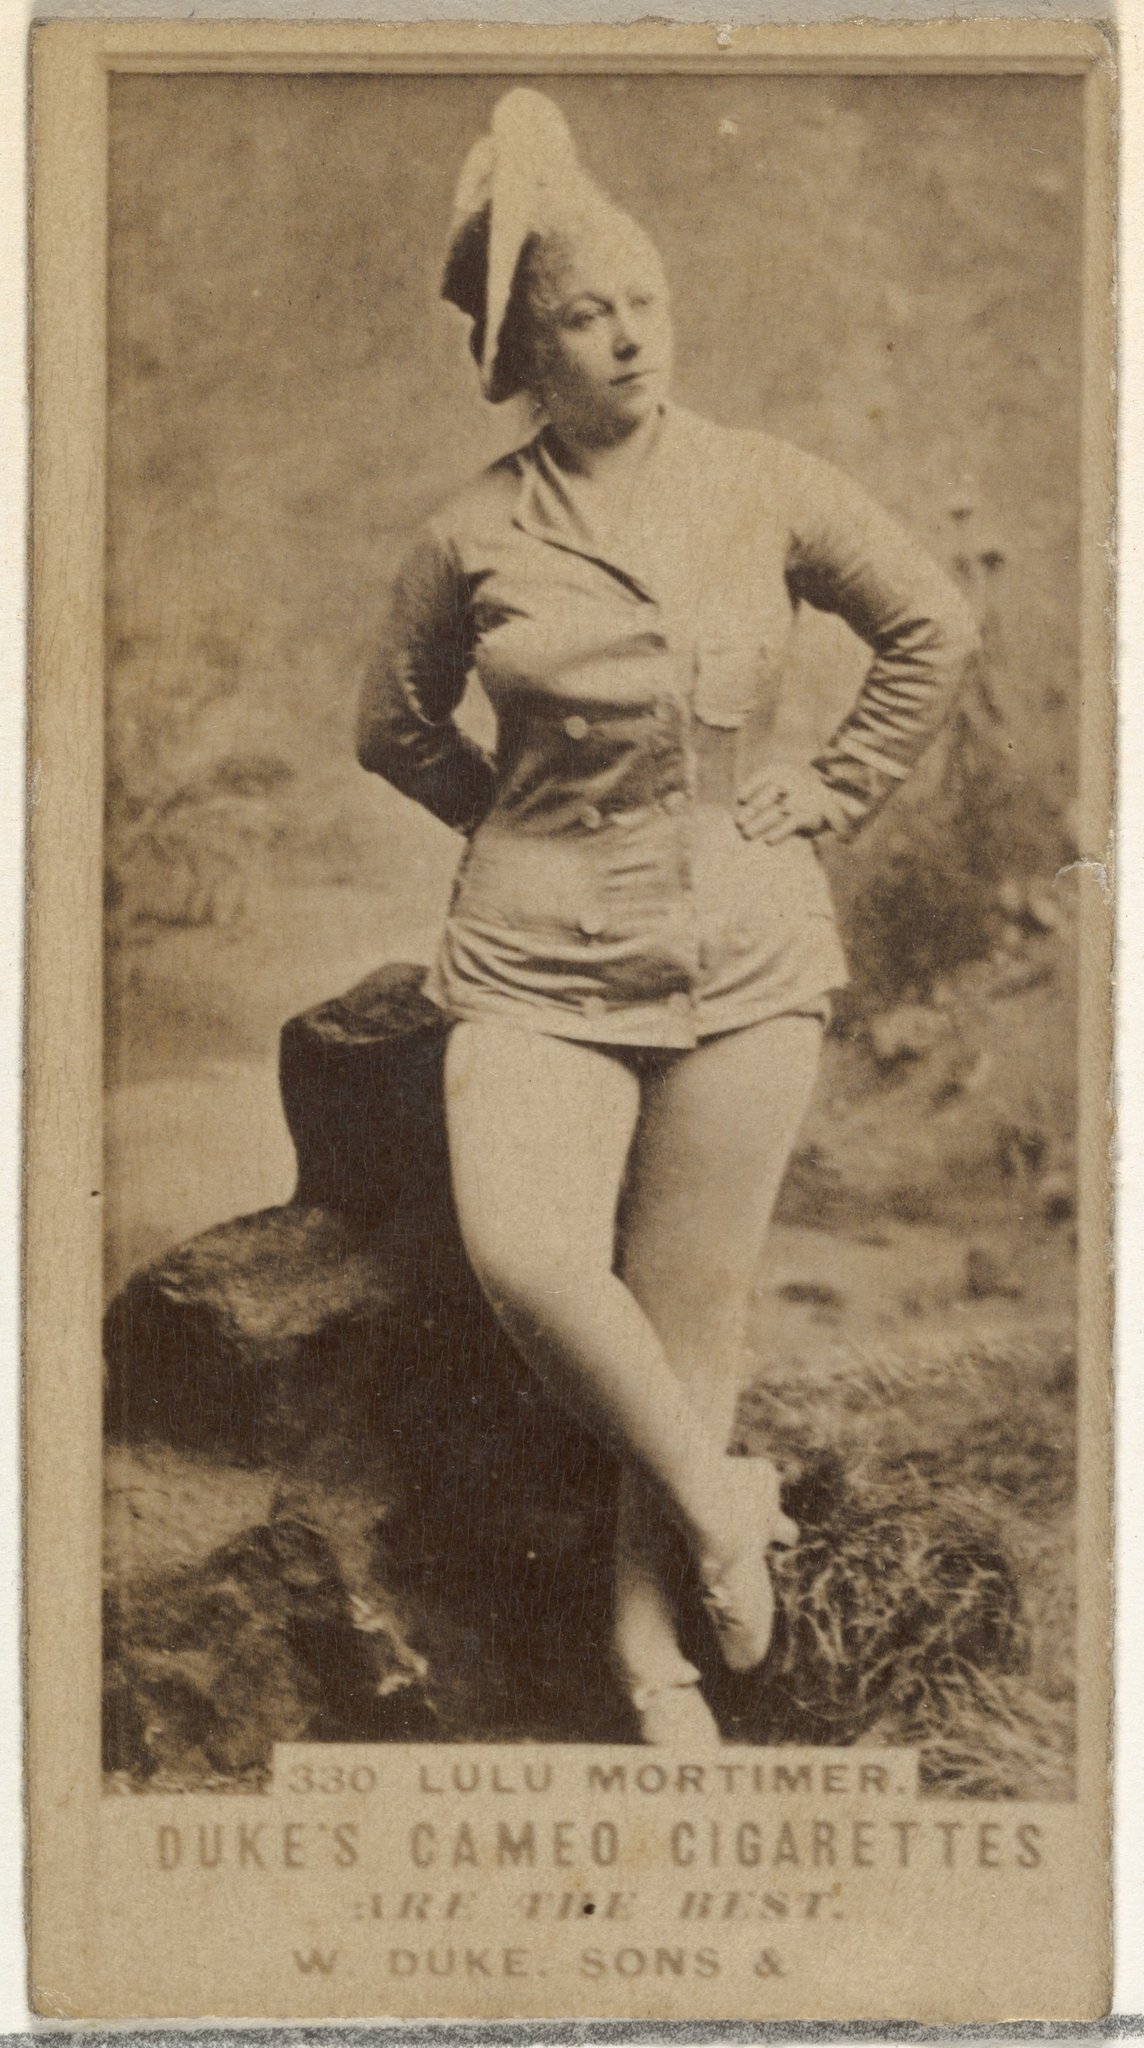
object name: photograph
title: Card Number 330, Lulu Mortimer, from the Actors and Actresses series (N145-5) issued by Duke Sons & Co. to promote Cameo Cigarettes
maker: w. duke, sons & co.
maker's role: publisher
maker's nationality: american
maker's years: 1870-1920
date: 1880-1889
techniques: albumen silver print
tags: portraits,women,actresses